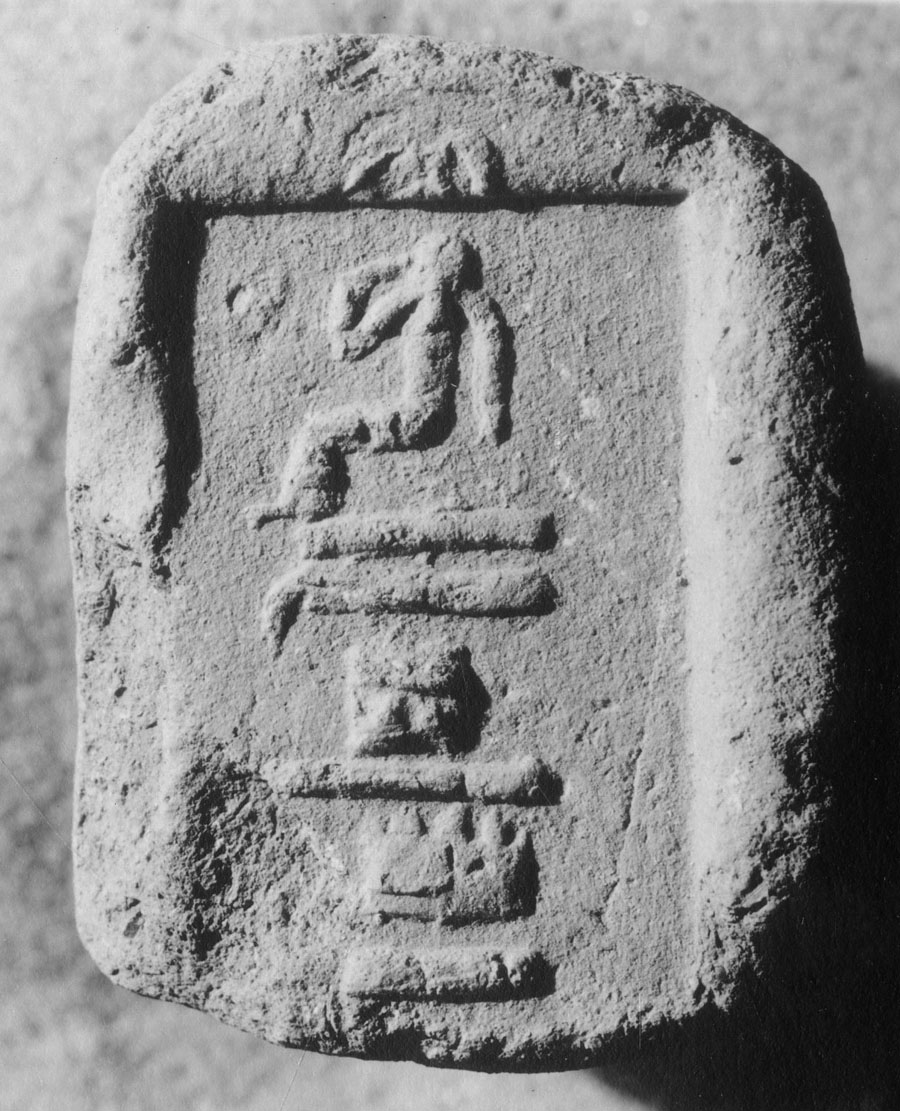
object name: cone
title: Funerary Cone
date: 1550-1295 BCE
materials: pottery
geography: egypt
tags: hieroglyphs